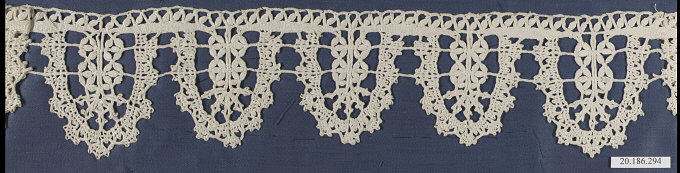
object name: edging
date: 1601-1700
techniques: lace